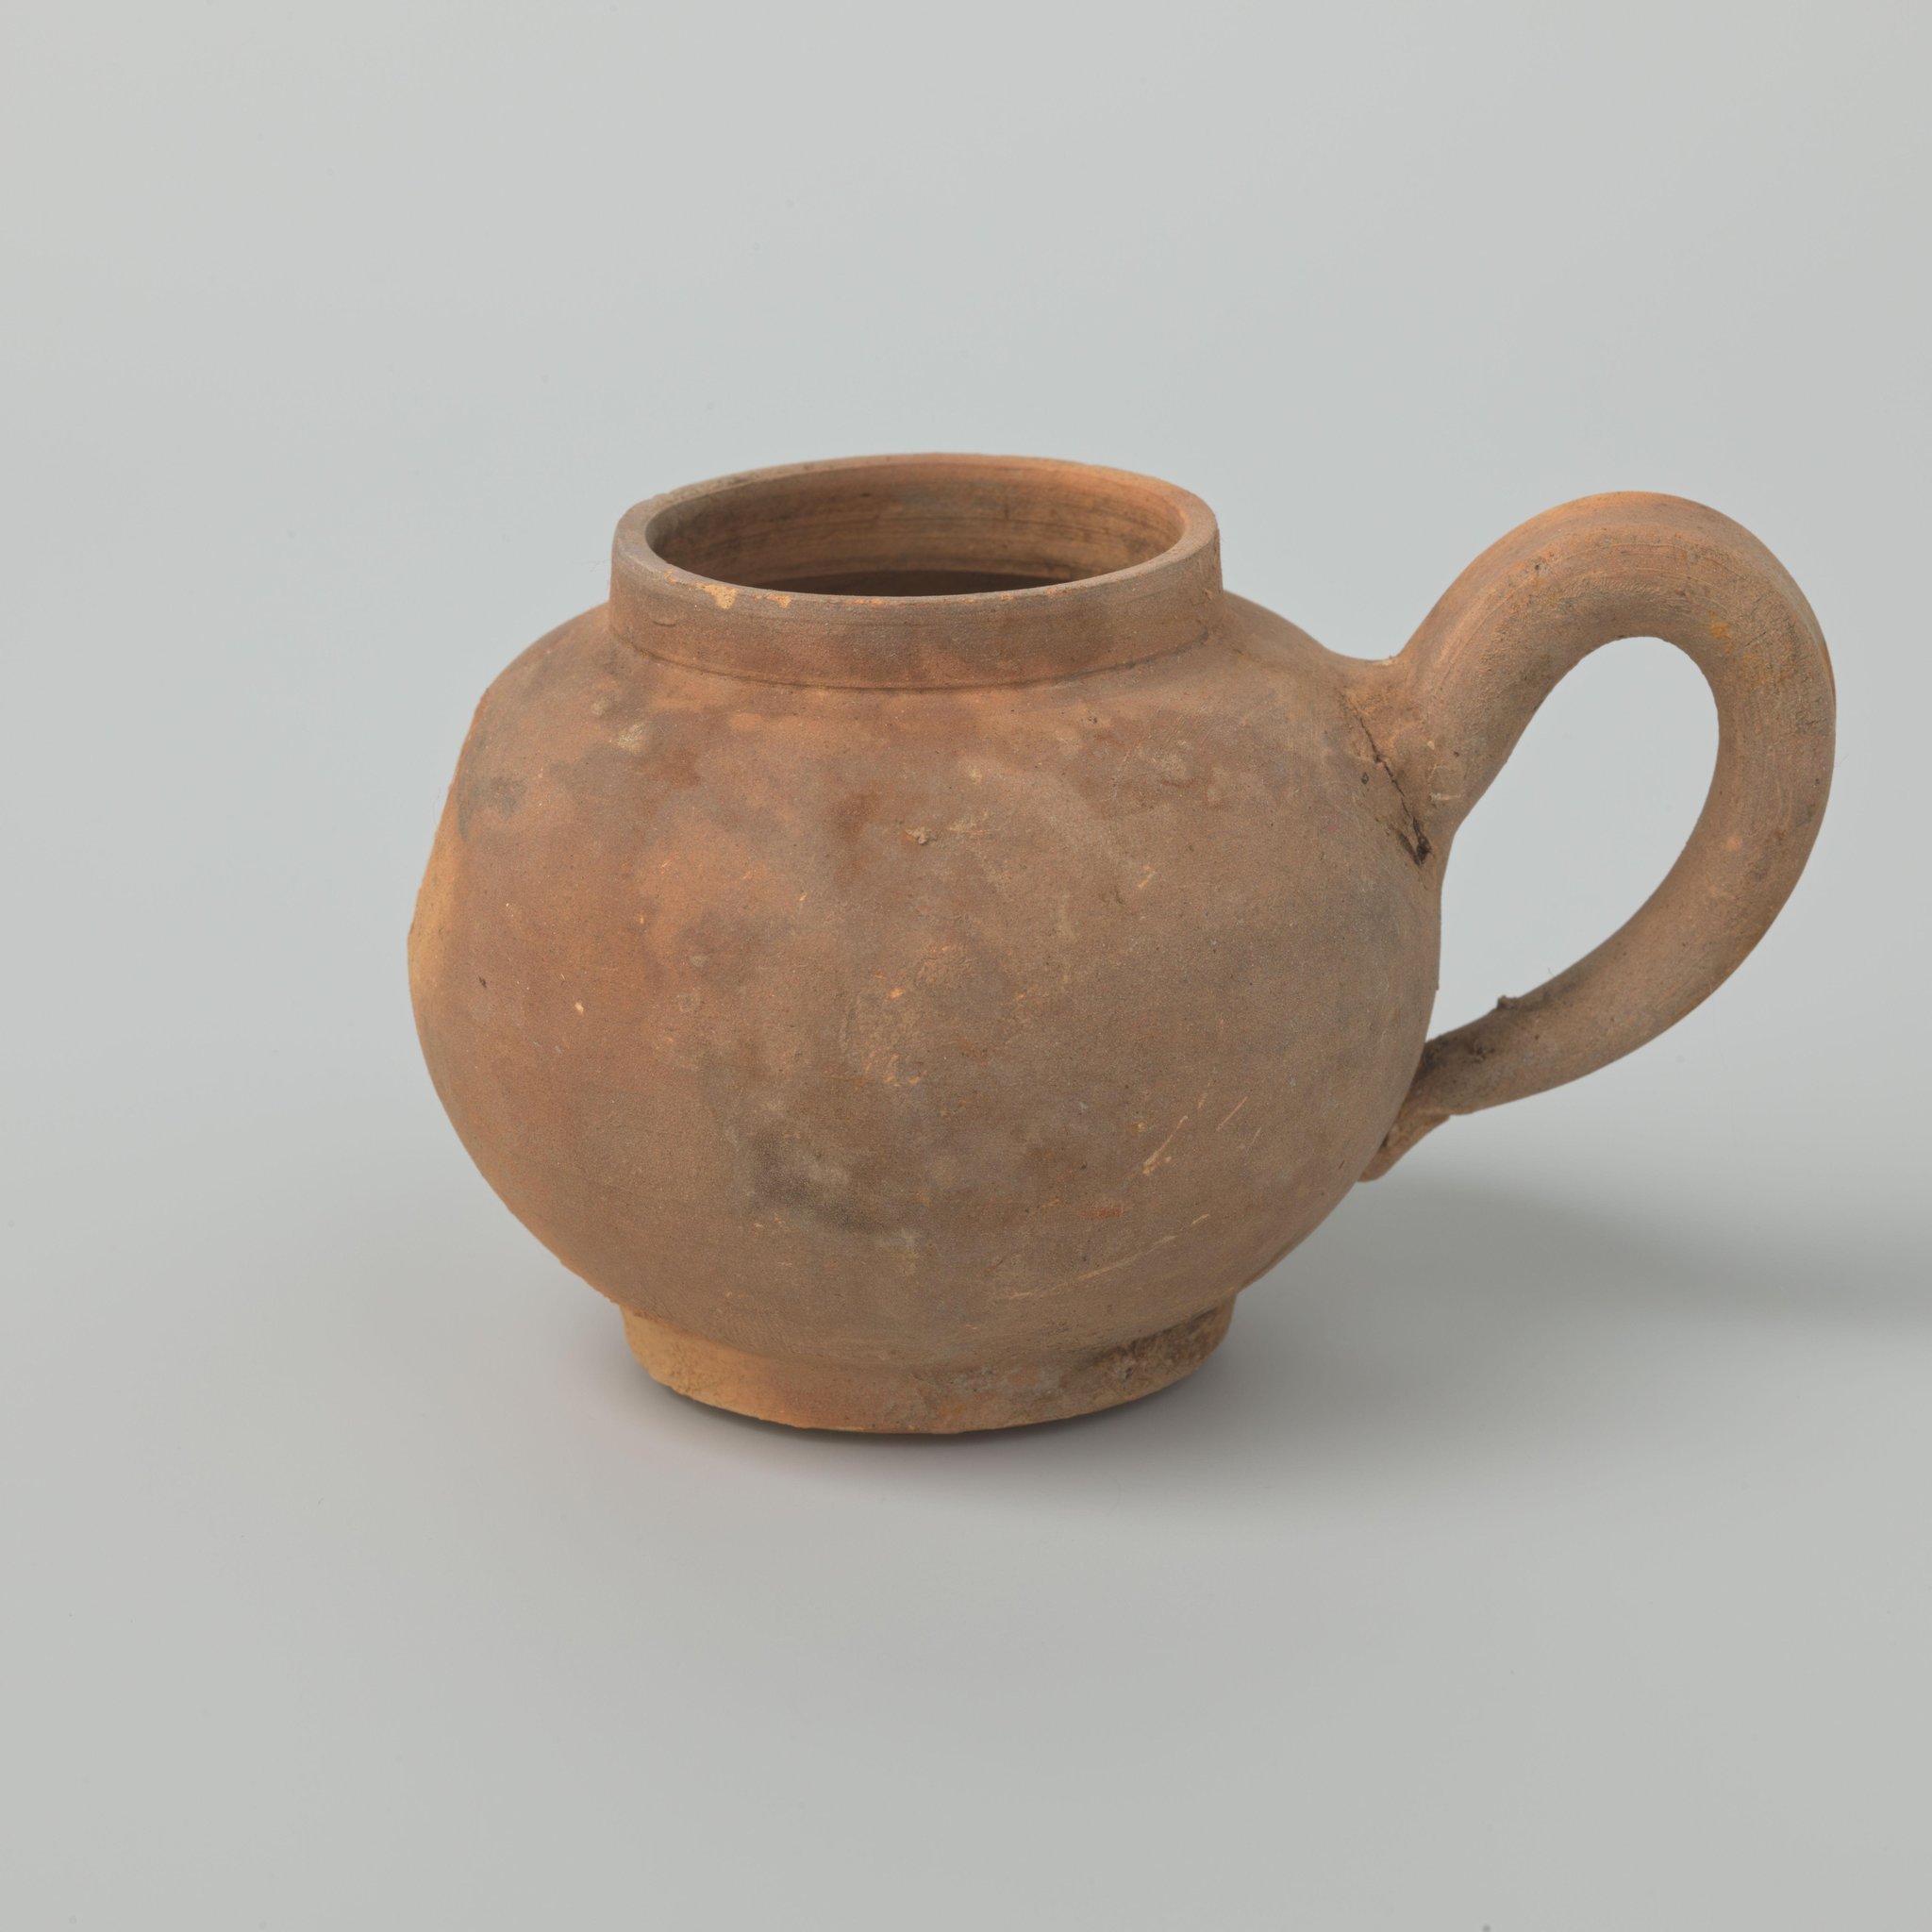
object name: teapot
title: Theepot van ongeglazuurd aardewerk (De Caluwe bakafval)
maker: jacobus de caluwe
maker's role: plateelbakkerij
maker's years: -1730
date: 1700-1725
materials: earthenware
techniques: firing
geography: delft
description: Toegeschreven aan Jacobus de Caluwe, omdat dit voorwerp samen met gemerkte stukken (‘Jacobus De Caluwe’ en rennend hert) gevonden is op de plaats waar zich De Caluwes tweede werkplaats bevond. Er is een duidelijke stilistische overeenkomst tussen de gemerkte en niet gemerkte voorwerpen uit deze archeologische vondst.